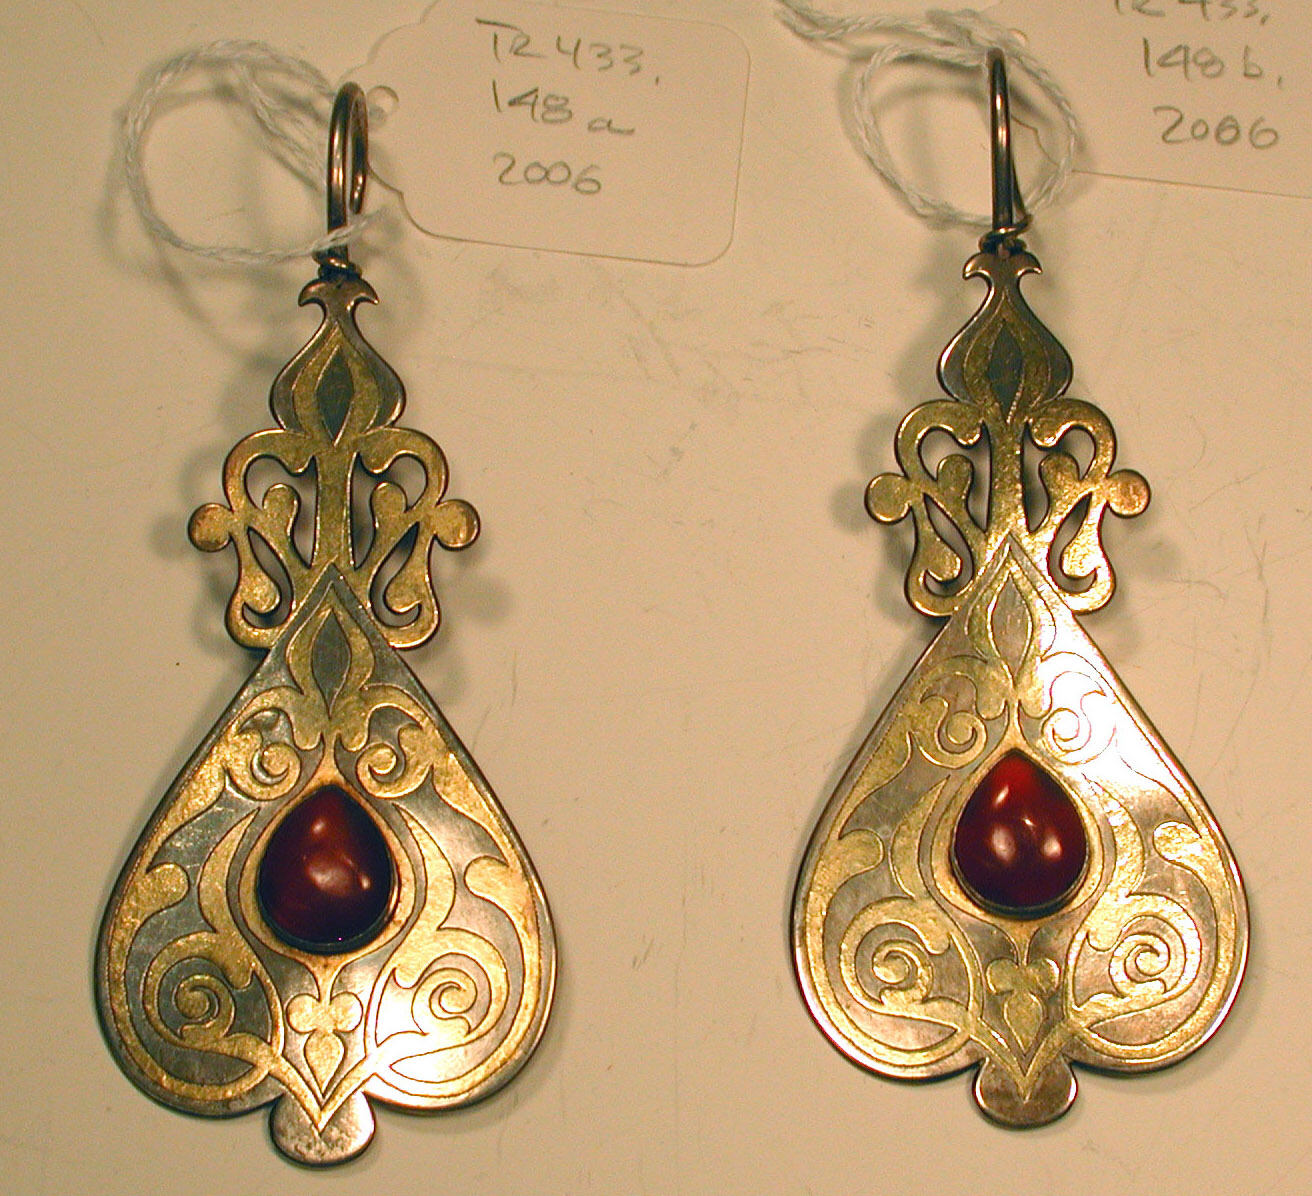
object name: ornament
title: Short Temple Pendant, One of a Pair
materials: carnelian, silver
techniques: chasing, gilding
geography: central asia